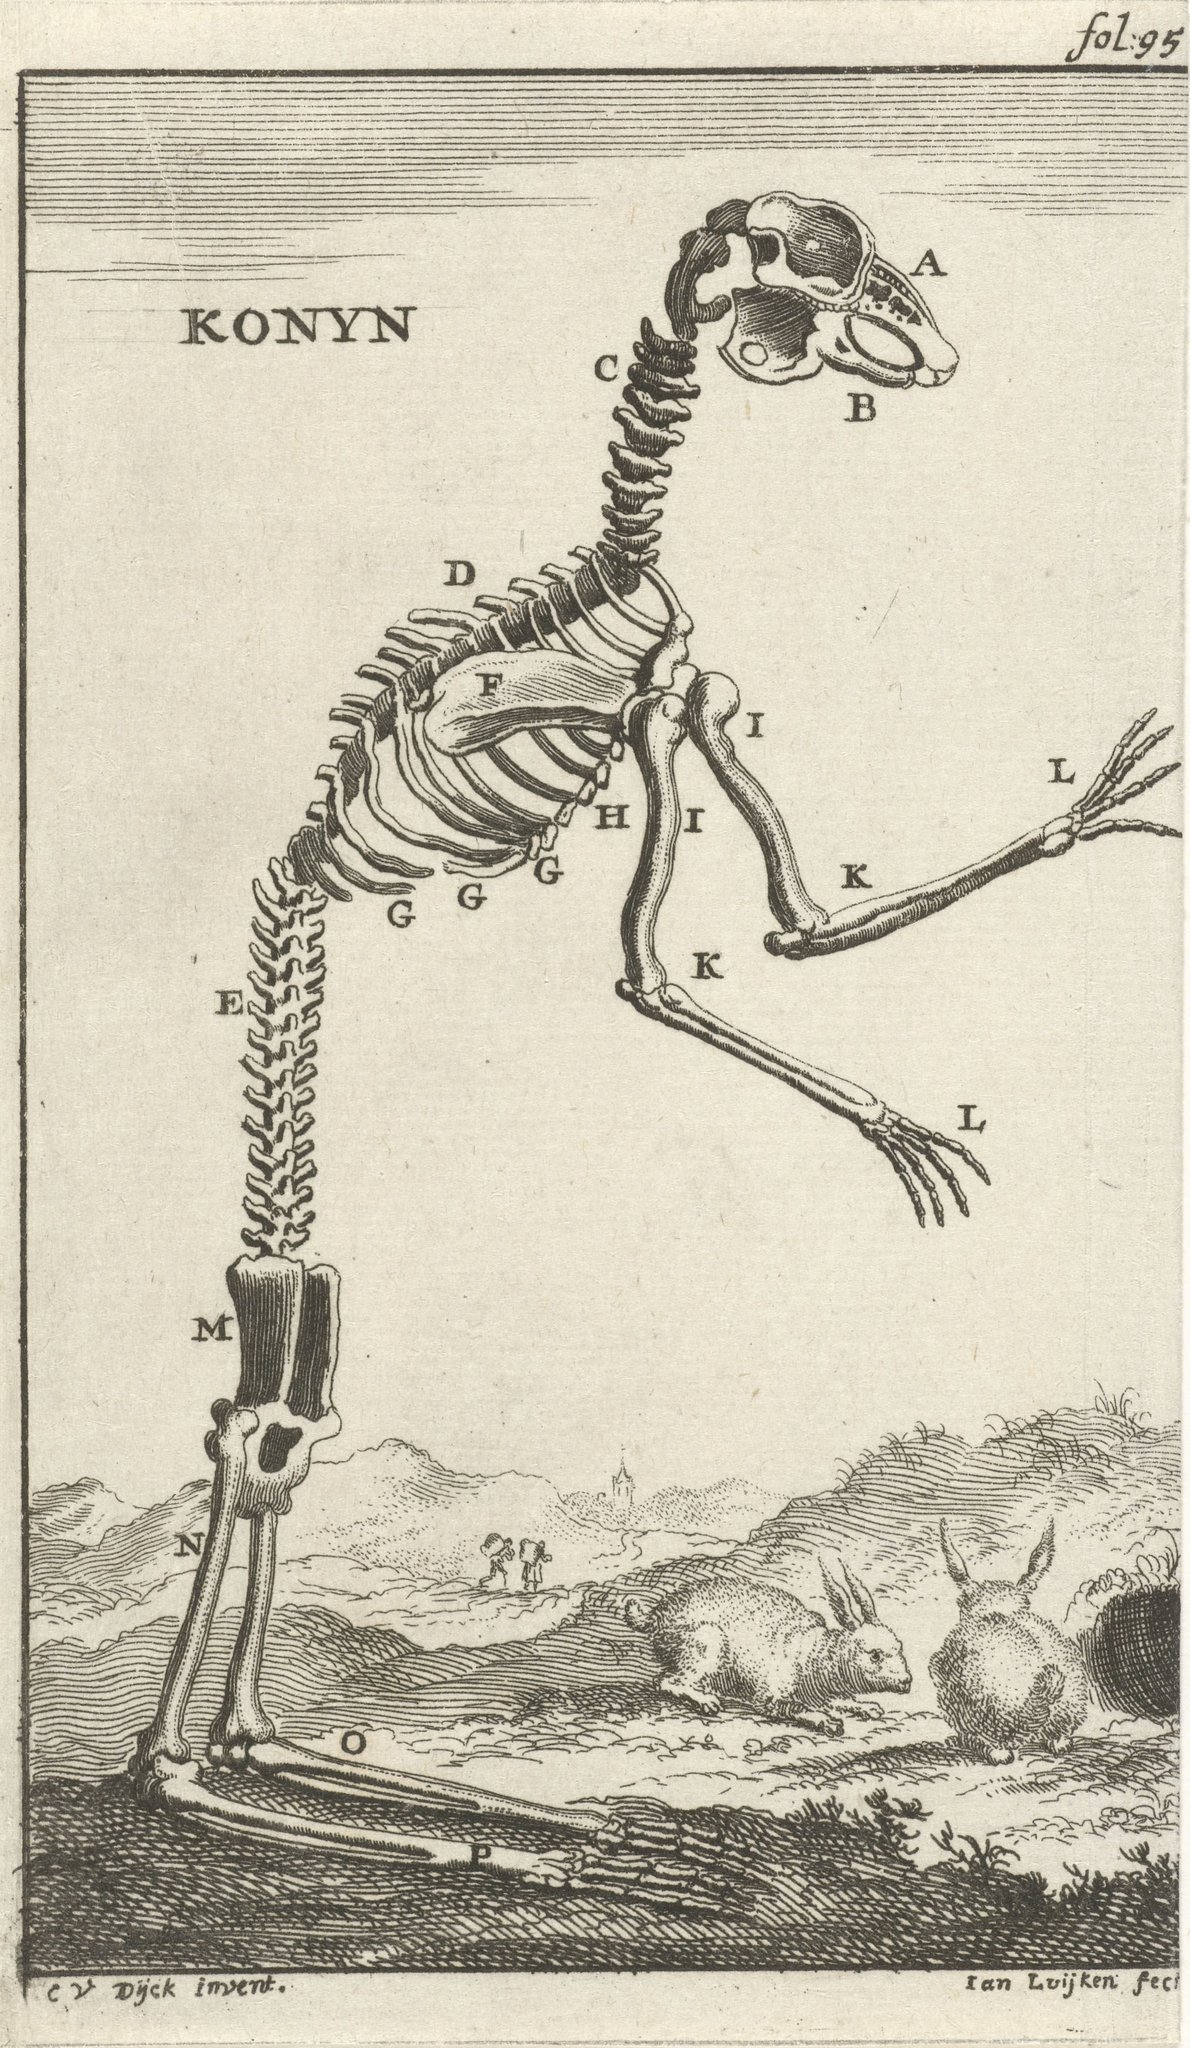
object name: print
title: Konyn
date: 1680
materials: paper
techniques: etching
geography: amsterdam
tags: animals (+ skeleton of an animal), rodents: rabbit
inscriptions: collector's mark: Lugt 2228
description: Illustratie opgenomen in: Dyk, Cornelis van. Osteologia, of nauwkeurige geraamt beschryving van verscheyde dieren, nevens hare historien. Amsterdam: Jan Claesz ten Hoorn, 1680.